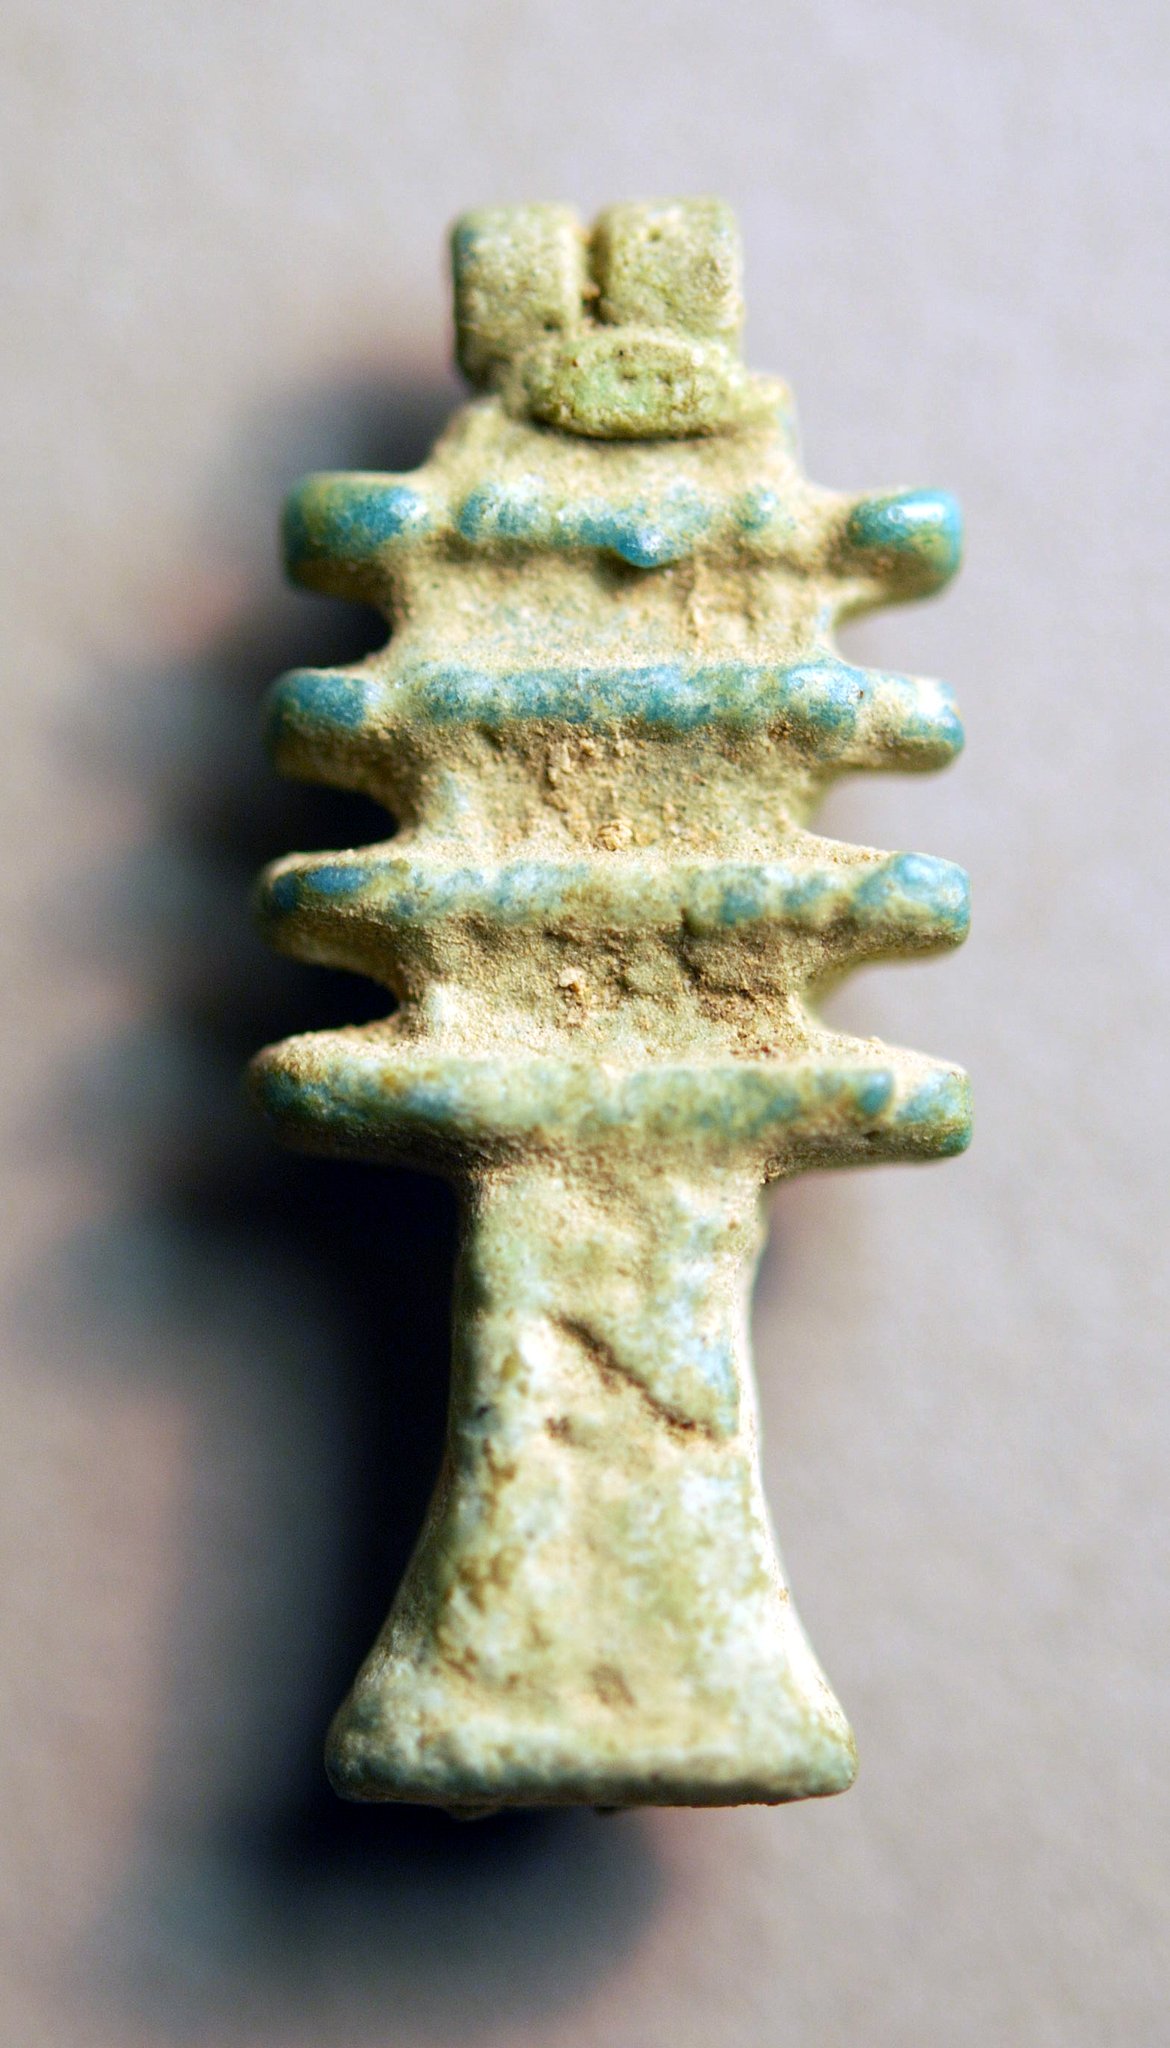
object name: amulet, djed pillar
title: Djed Amulet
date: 1390-1352 BCE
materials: faience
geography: egypt